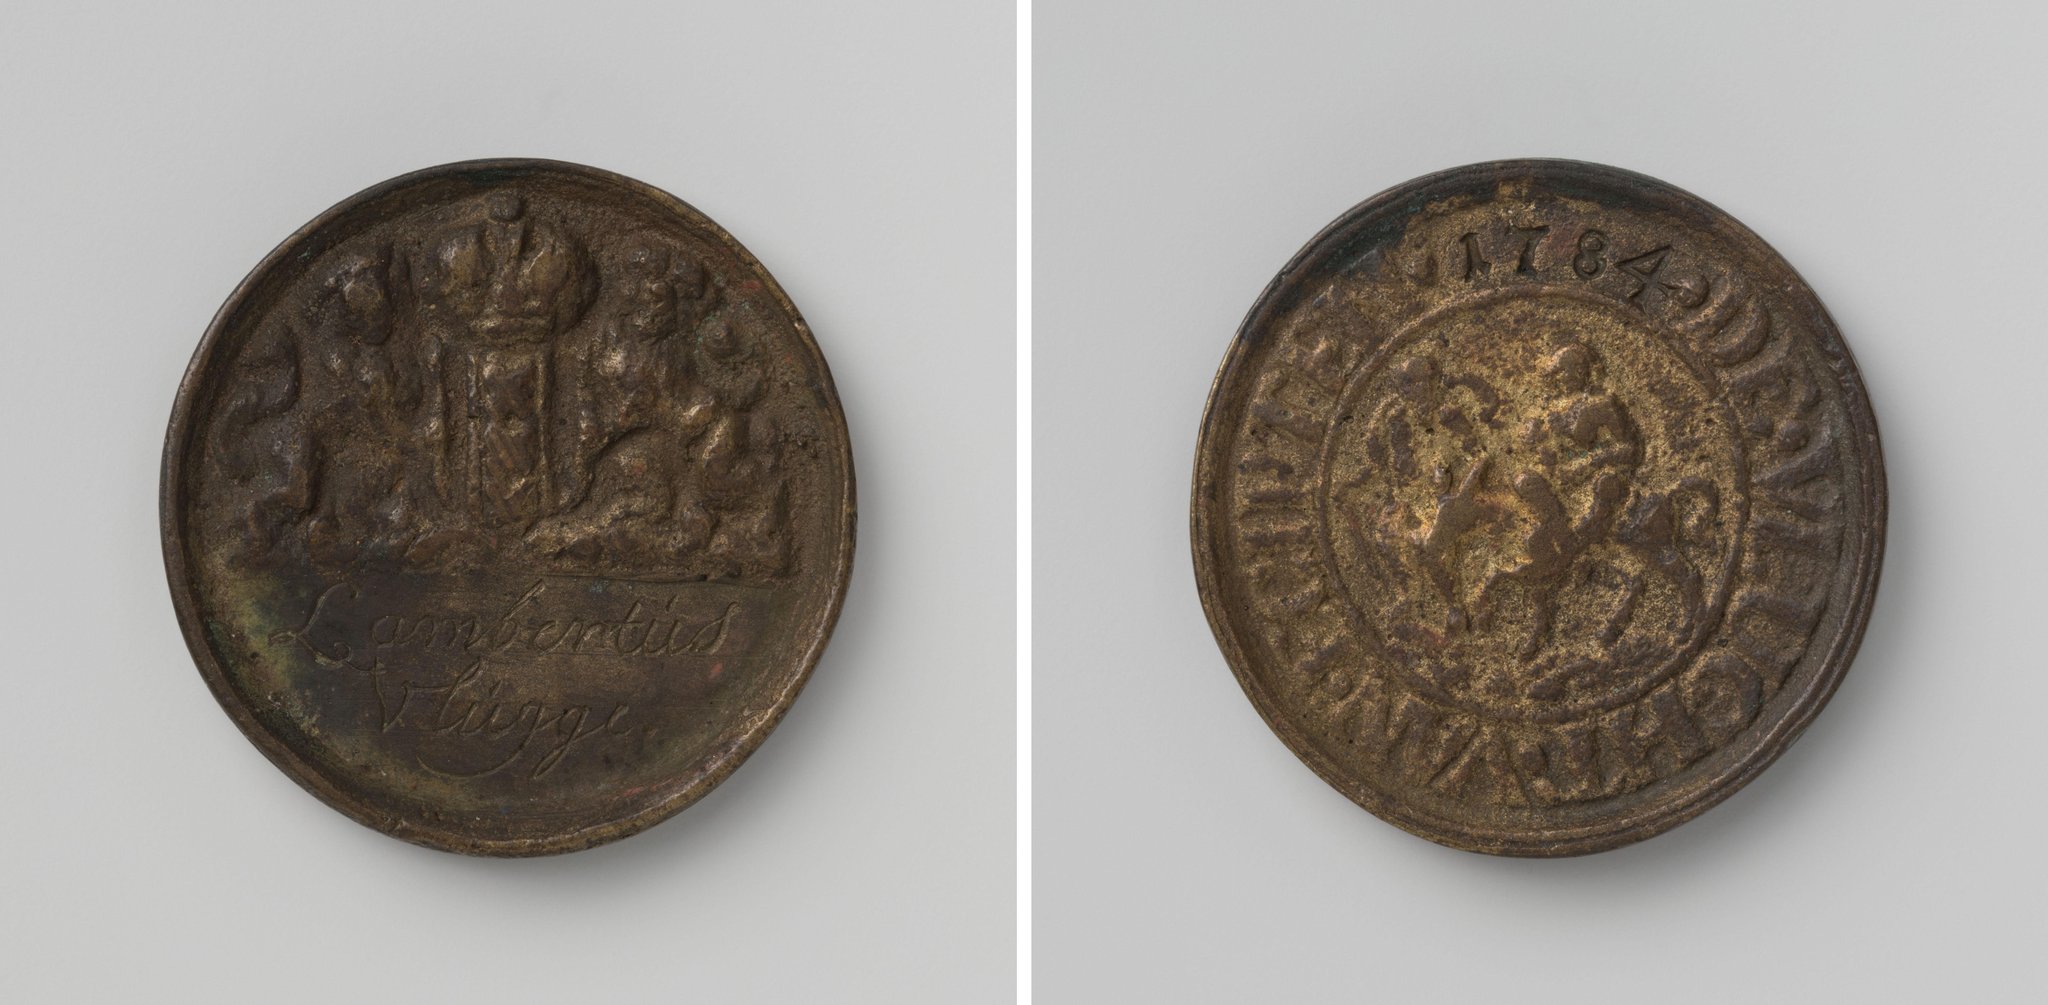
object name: medal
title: Timmerliedengilde van Amsterdam, gildepenning van Lambertus Vlugge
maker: Anonymous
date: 1784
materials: brass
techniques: casting, engraving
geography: amsterdam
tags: amsterdam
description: Messing penning. Voorzijde: gekroond wapenschild, geflankeerd door twee leeuwen; afsnede: opschrift. Keerzijde: Maria, zittend met kind op ezeltje, dat door Jozef geleid wordt binnen omschrift